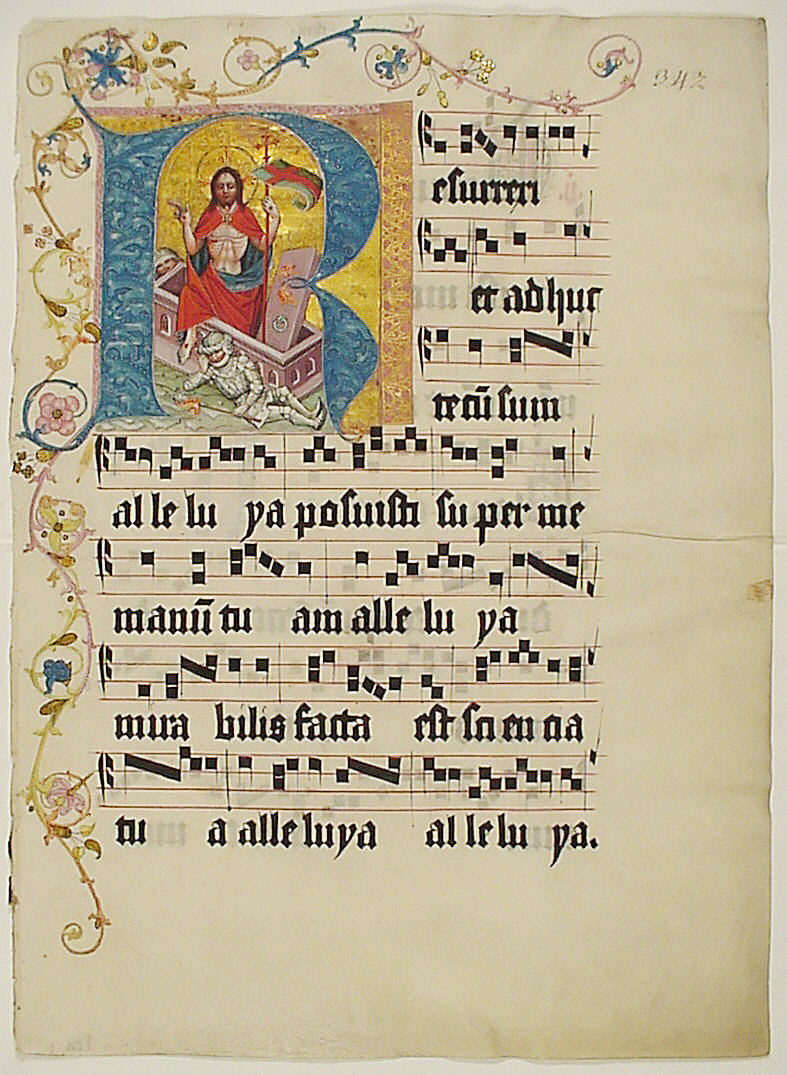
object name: gradual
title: Manuscript Leaf with Initial R, from a Gradual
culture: german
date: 1426-1450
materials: ink, metal leaf, parchment, paint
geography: germany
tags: men,music